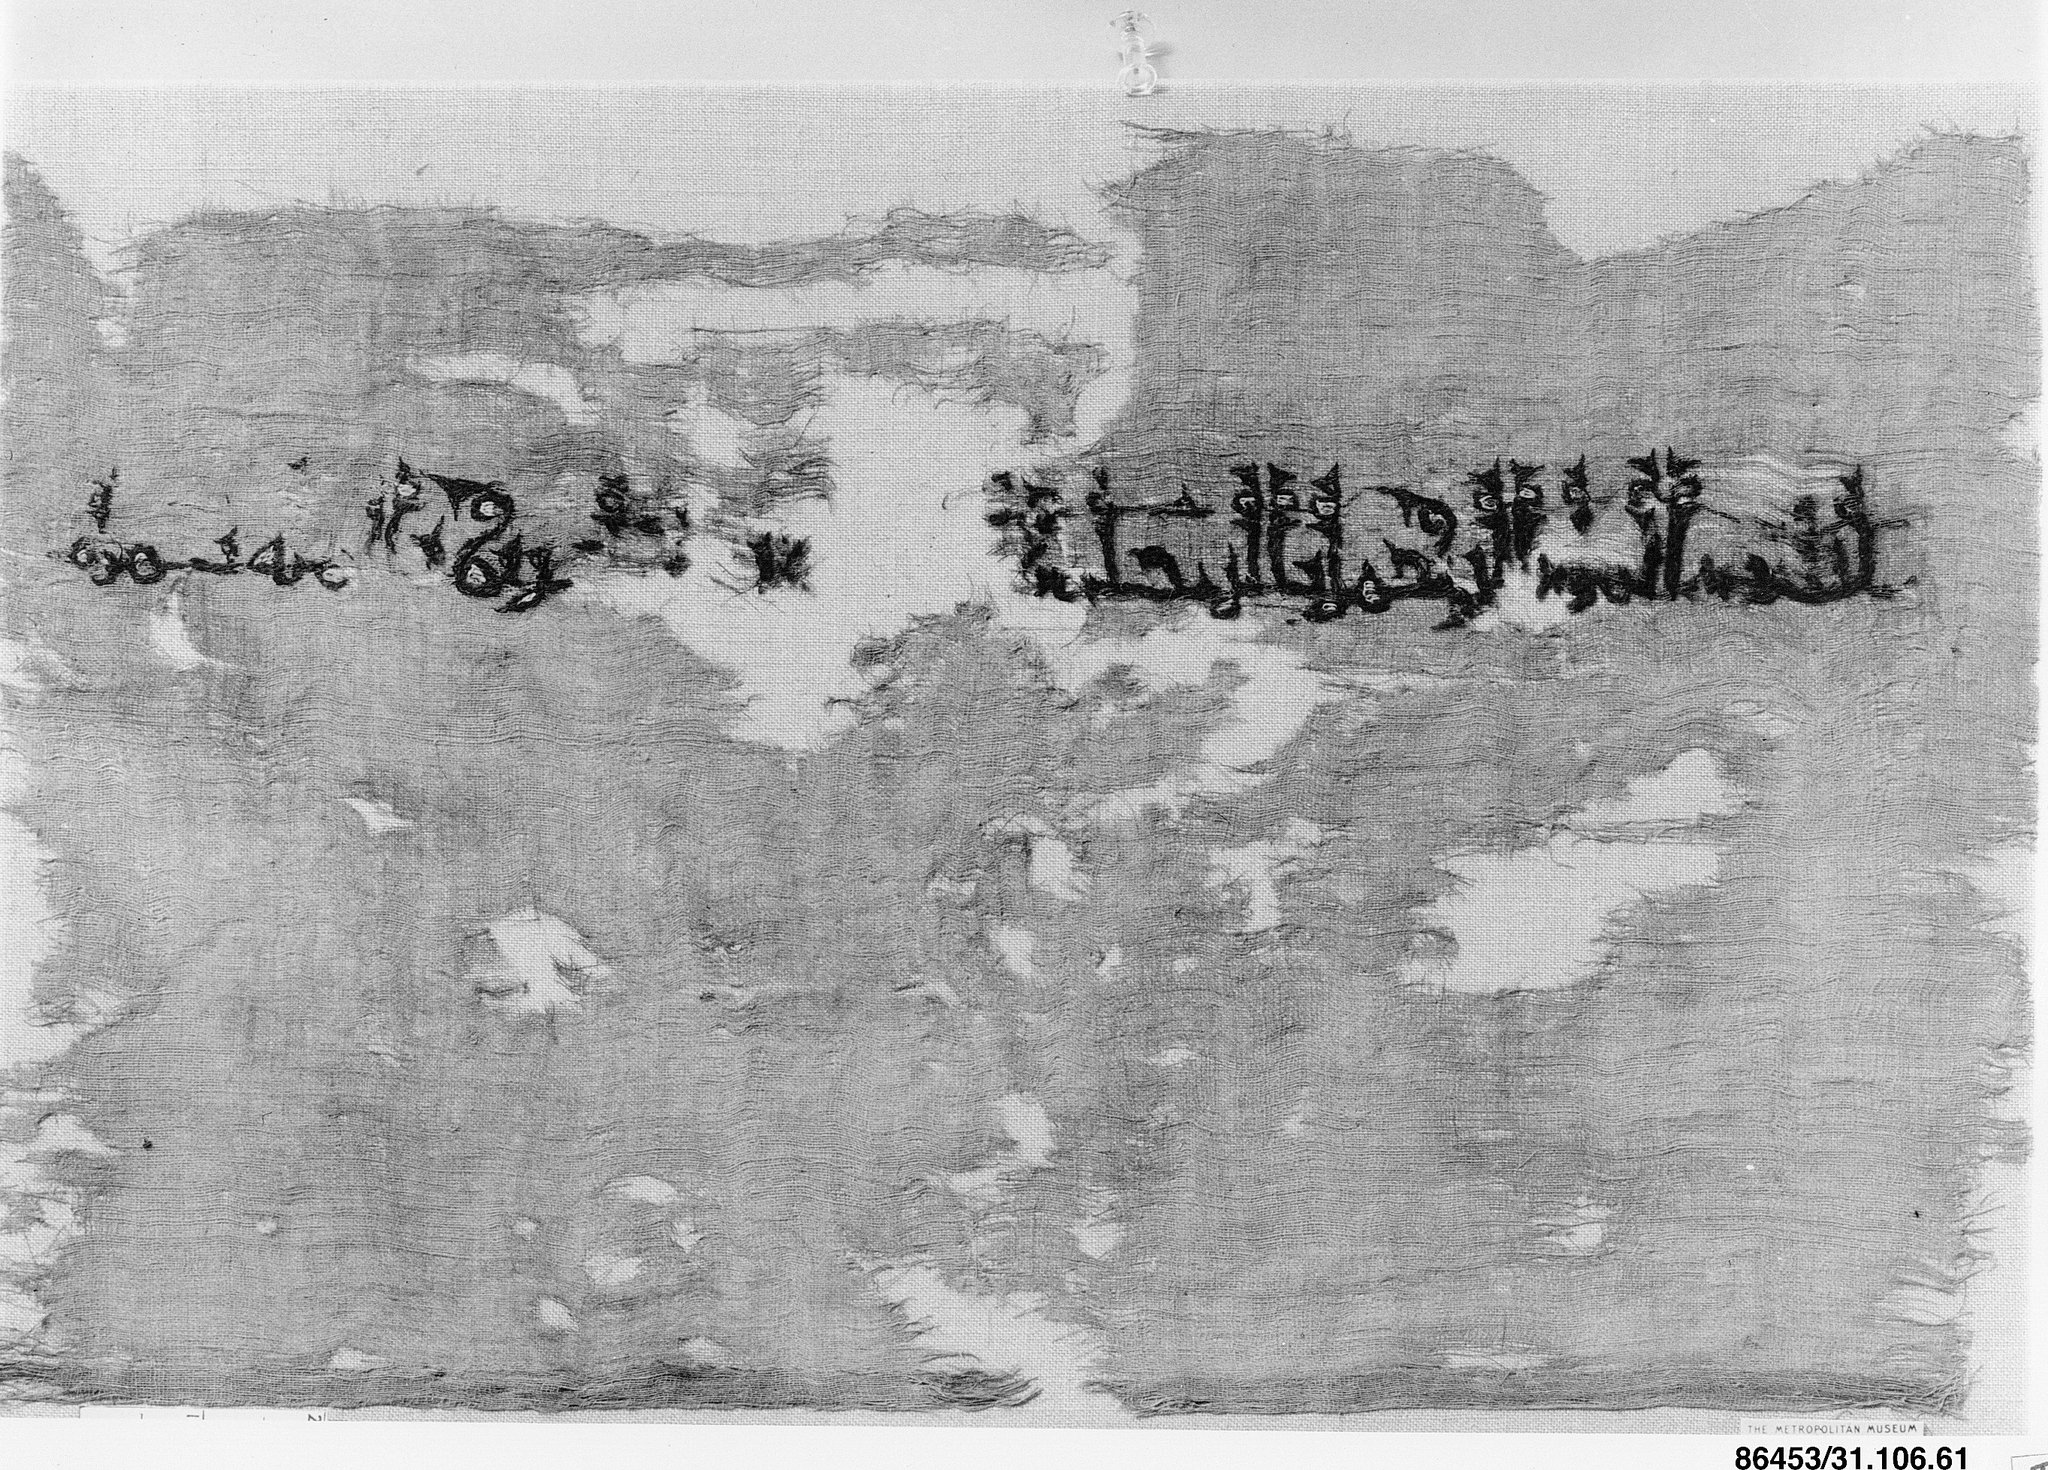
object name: textile fragment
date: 901-1000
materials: linen, silk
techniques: embroidery, weave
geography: egypt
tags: arabic